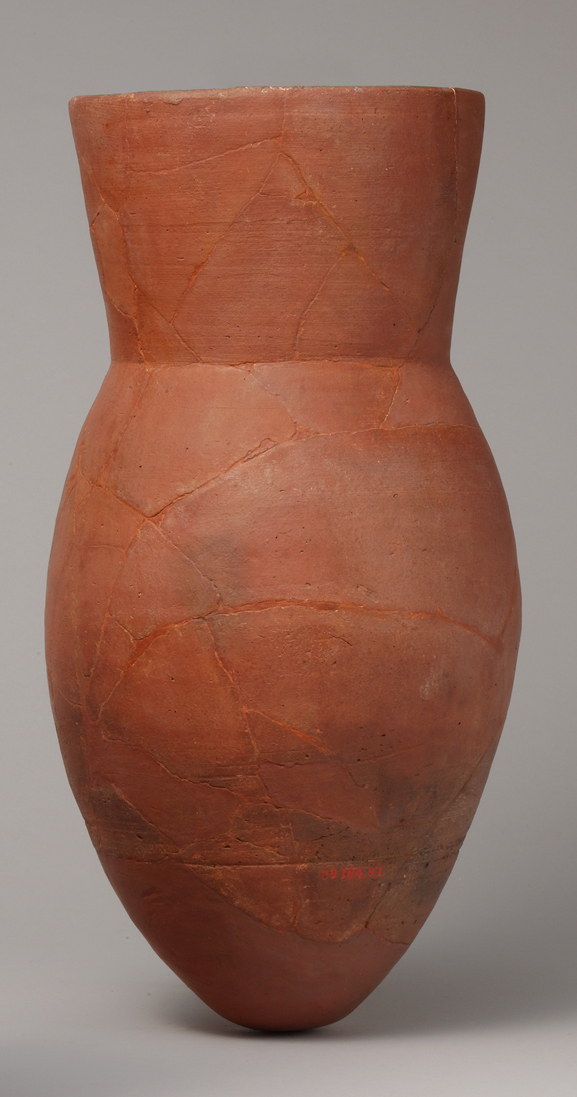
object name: jar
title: Jar from Tutankhamun's Embalming Cache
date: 1336-1327 BCE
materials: mineral, pottery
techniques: wash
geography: egypt